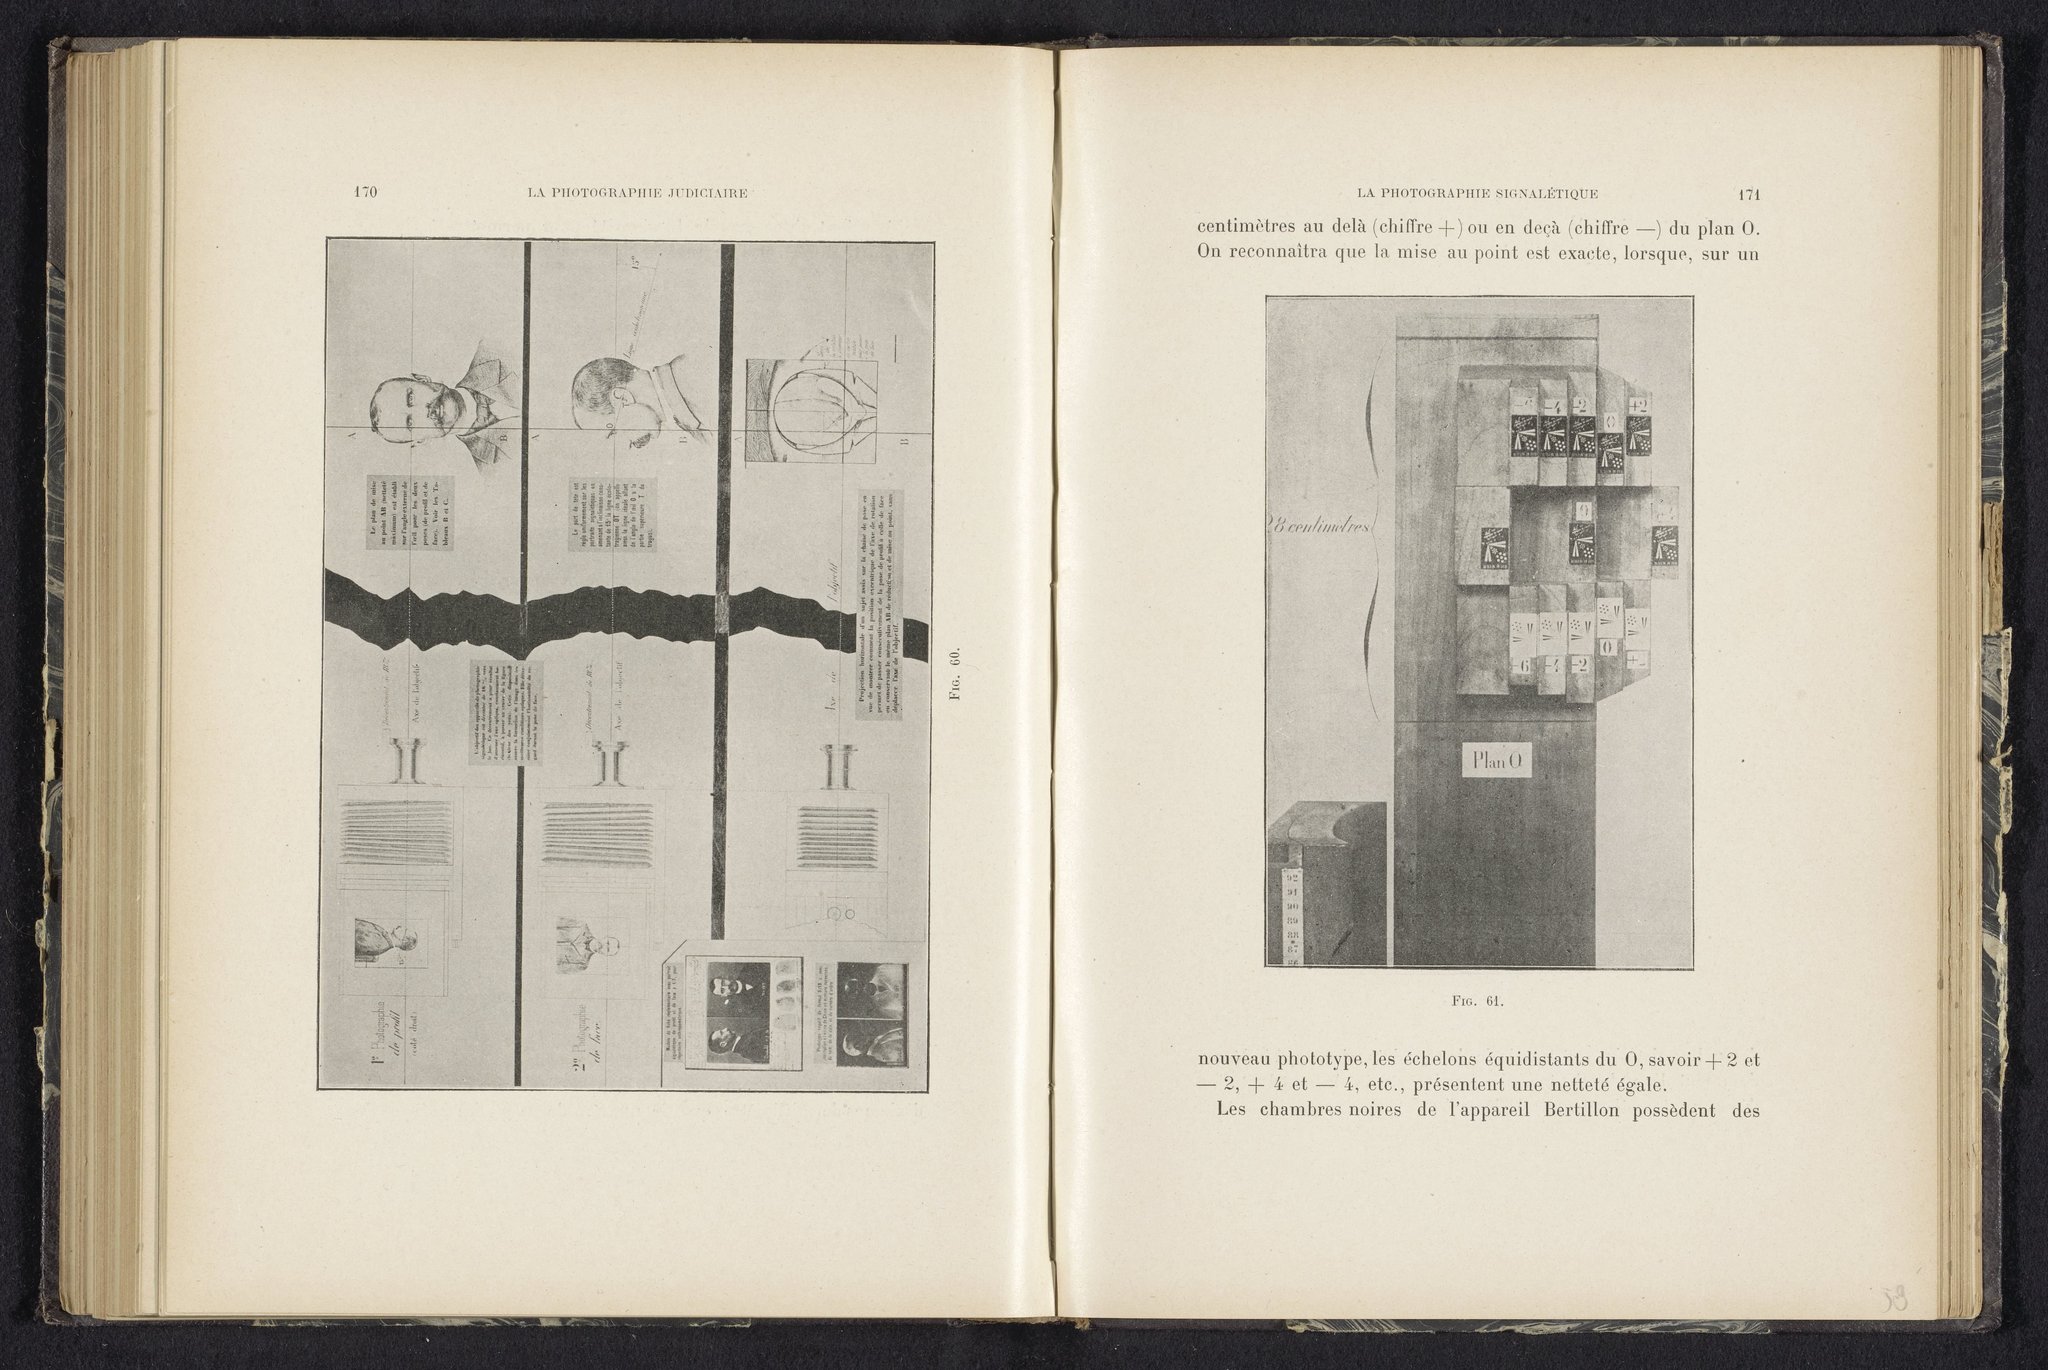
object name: page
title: Lensmeter voor het fotograferen van criminelen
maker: Anonymous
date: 1893-1903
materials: paper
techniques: autotype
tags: tools, aids, implements ~ crafts and industries, photography, criminals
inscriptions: number: ‘Fig. 61.’